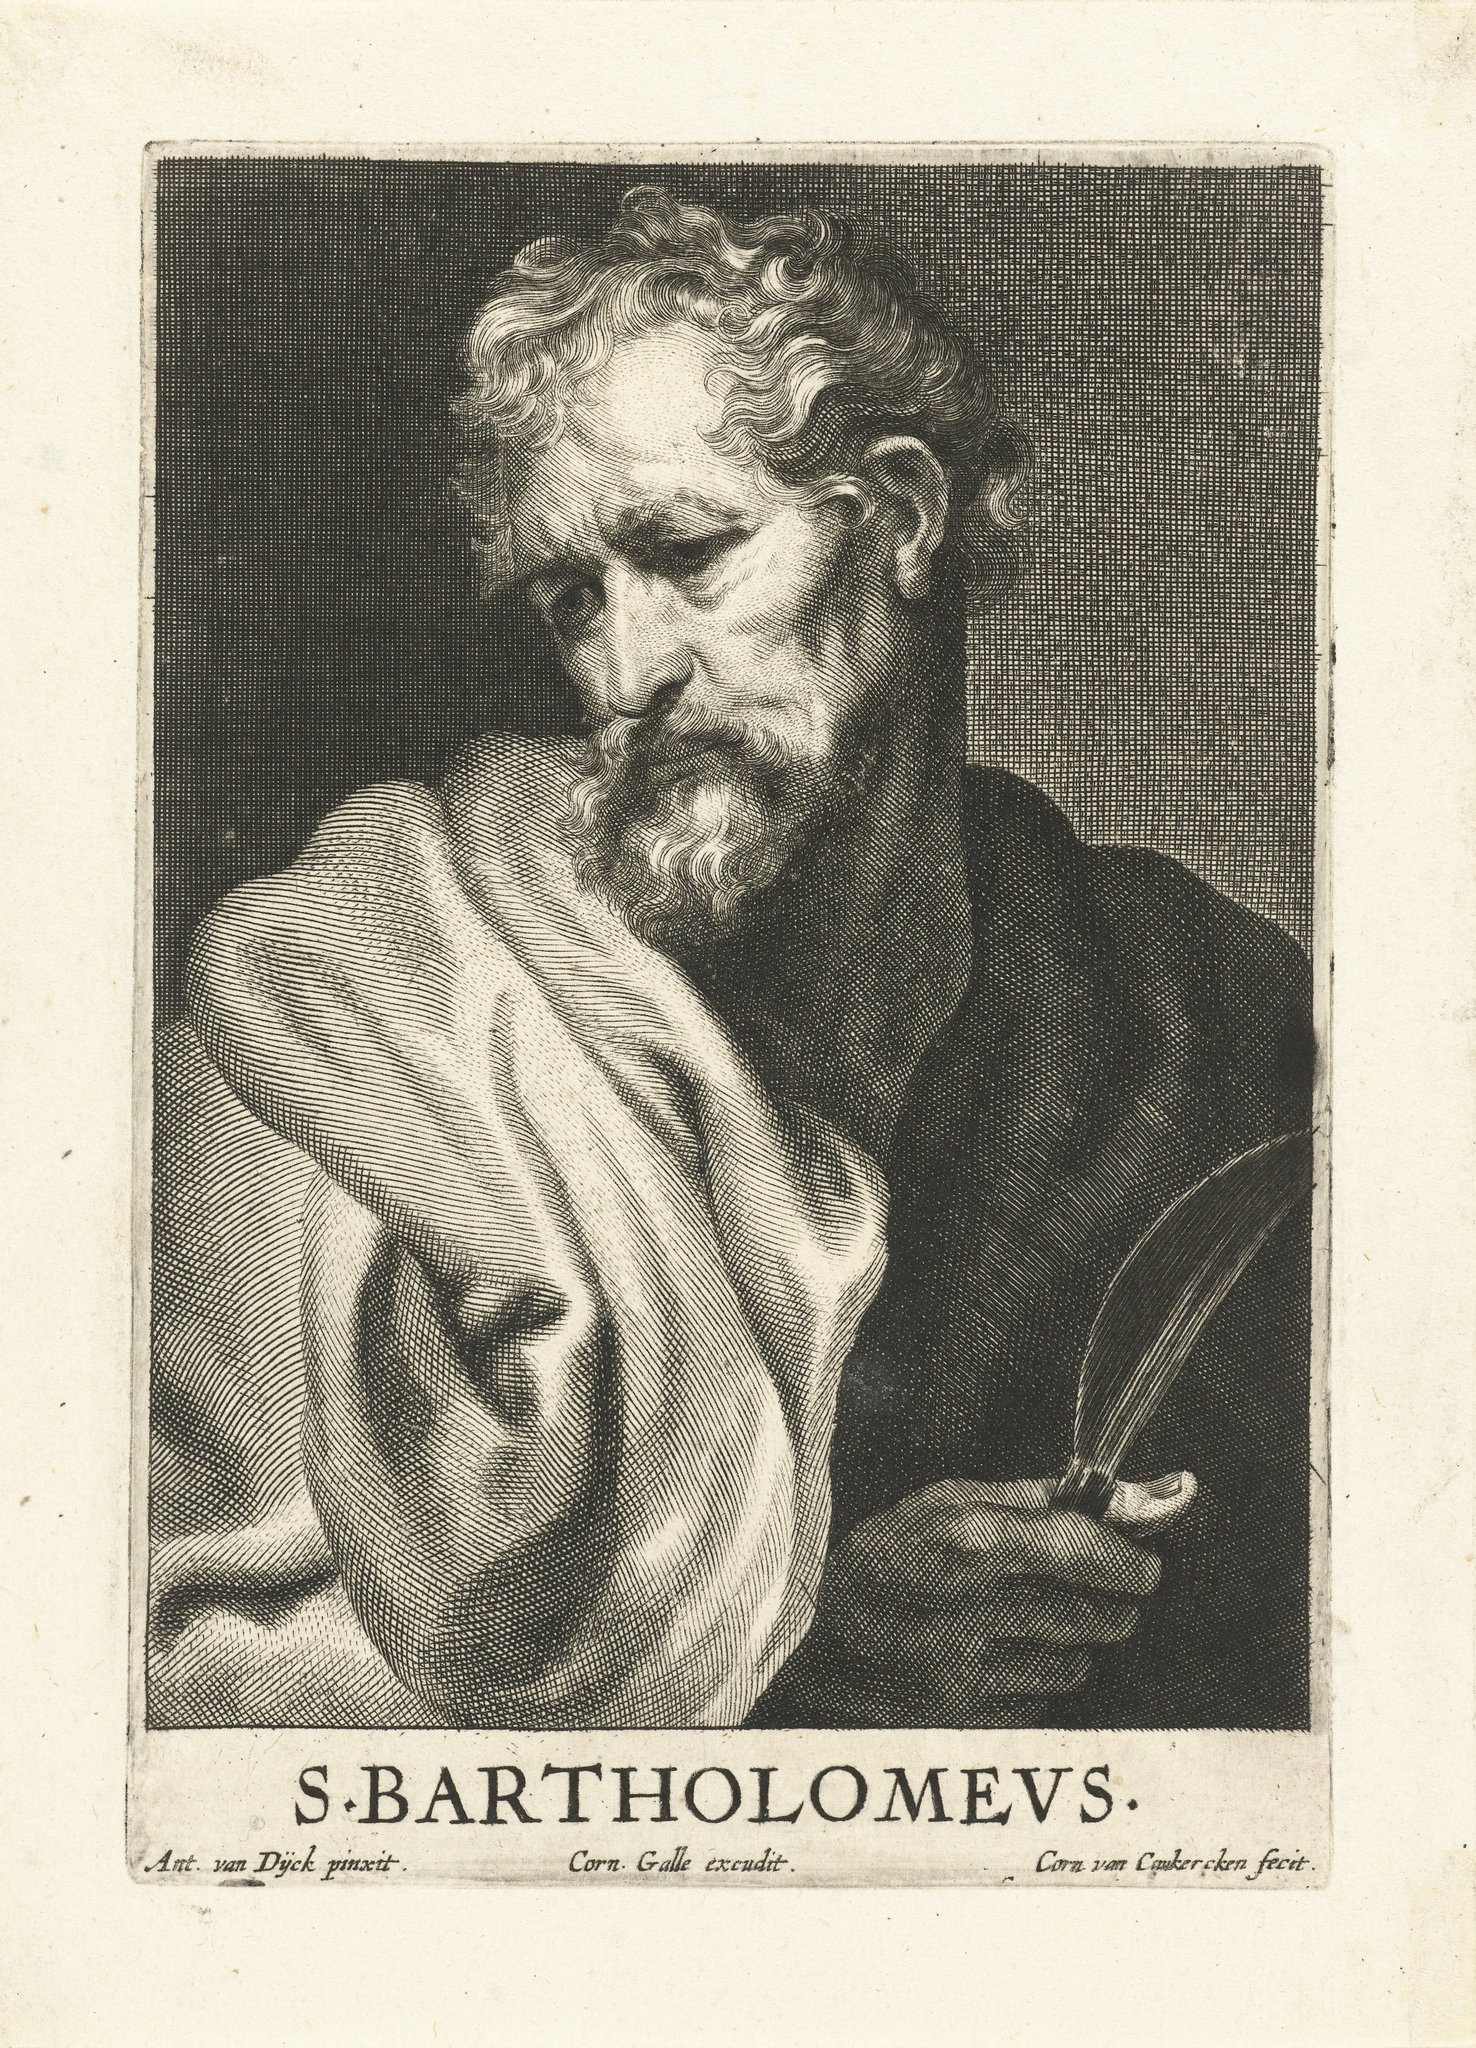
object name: print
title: Christus en de apostelen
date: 1640-1680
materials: paper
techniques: engraving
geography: antwerp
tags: the apostle bartholomew; possible attributes: book, devil or dragon at feet, knife, scroll, flayed skin, staff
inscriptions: collector's mark: Lugt 240